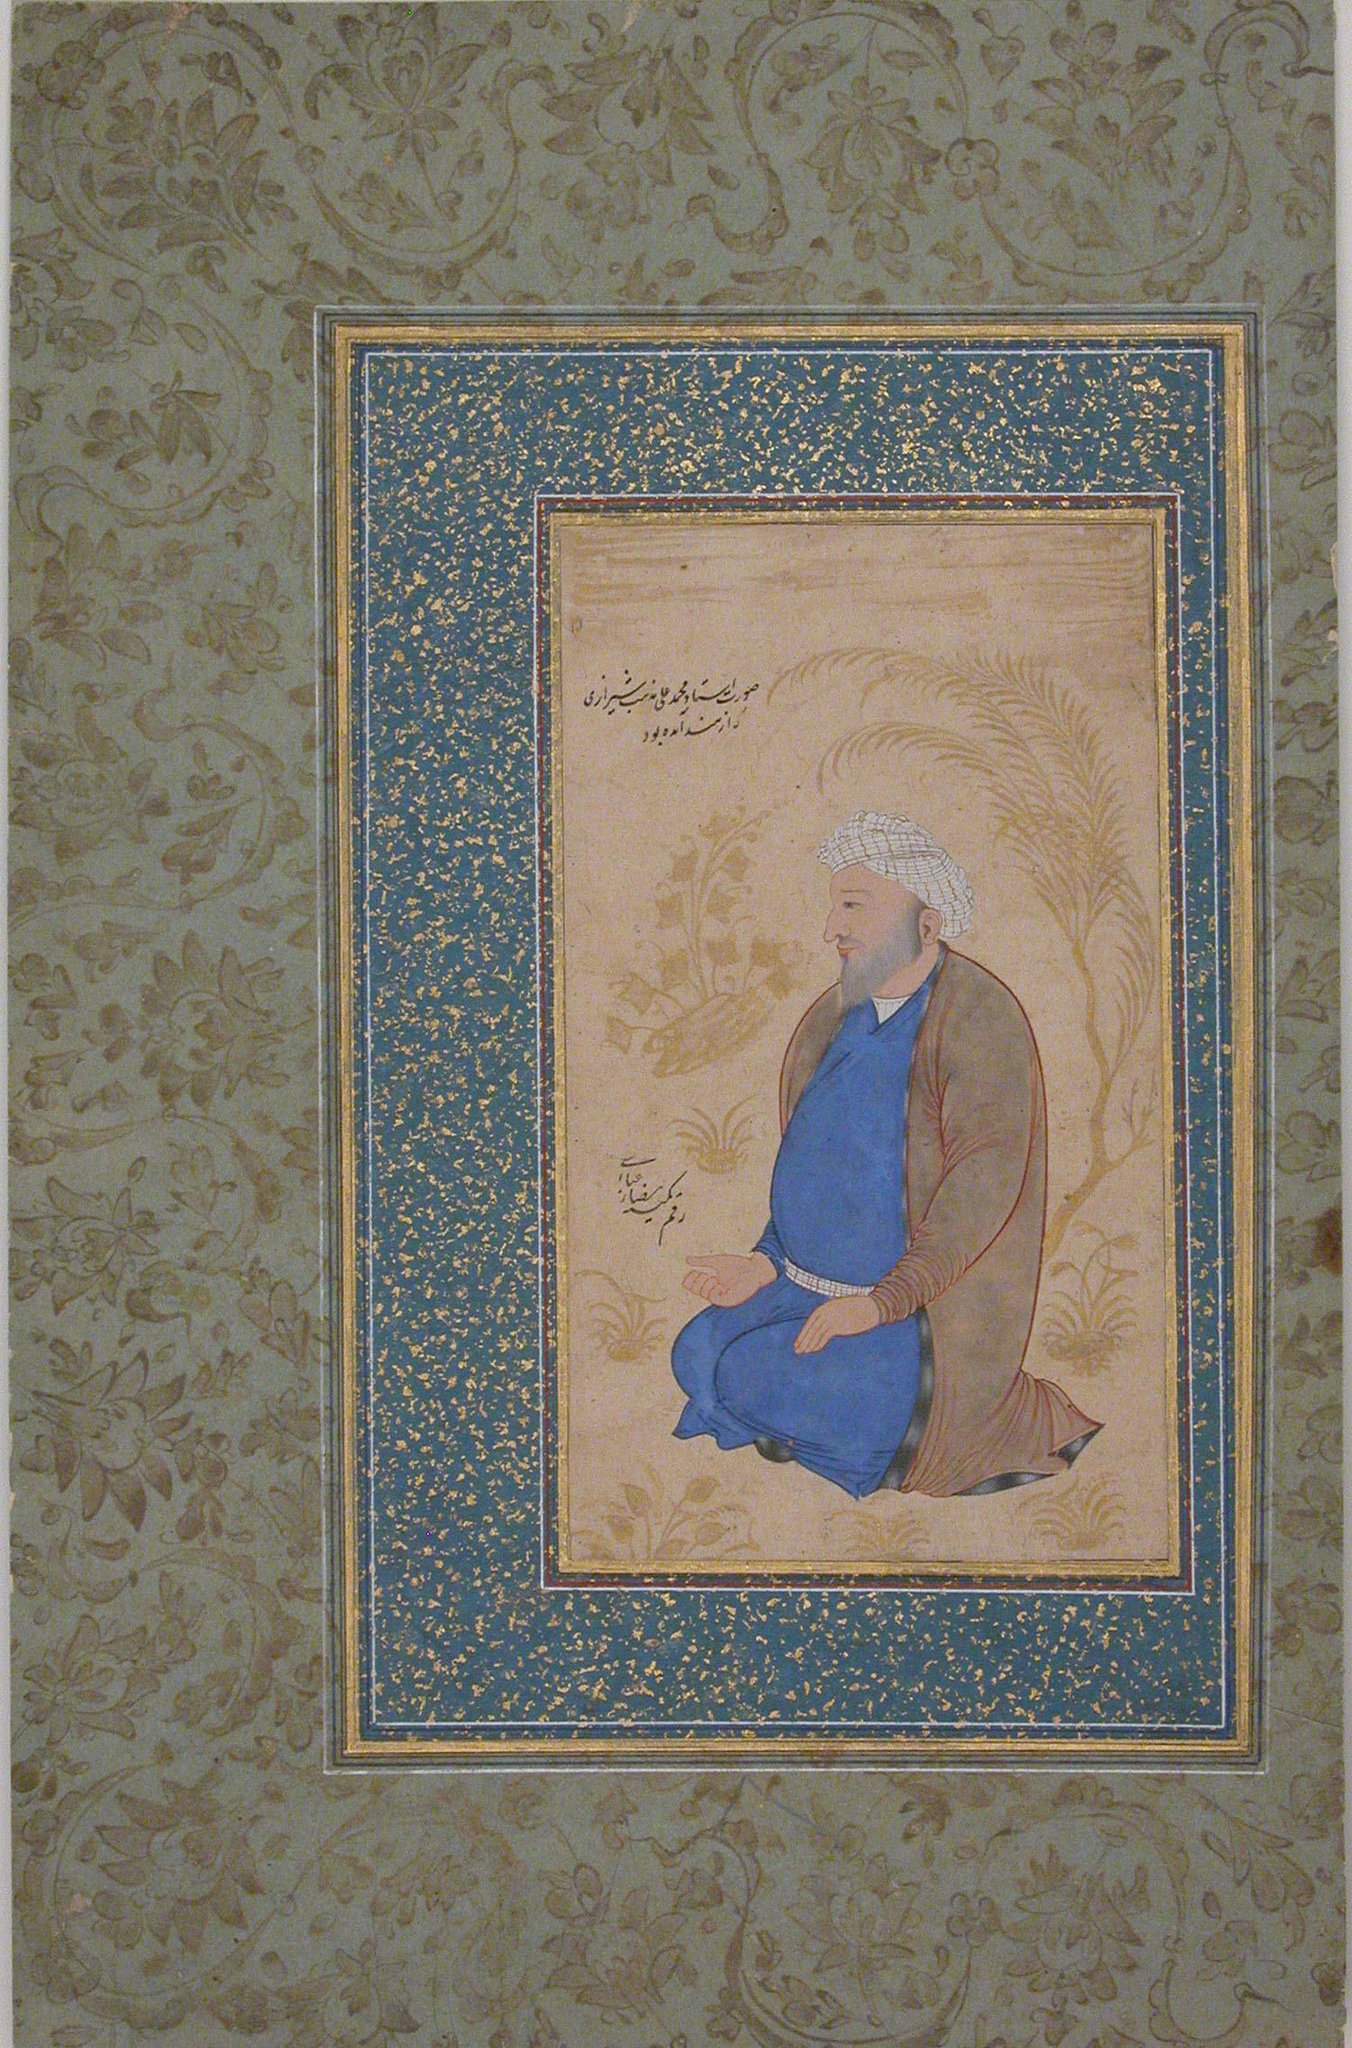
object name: illustrated album leaf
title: Portrait of Ustad Muhammad Ali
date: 1601-1700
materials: gold, paper, watercolor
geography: iran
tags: men,profiles